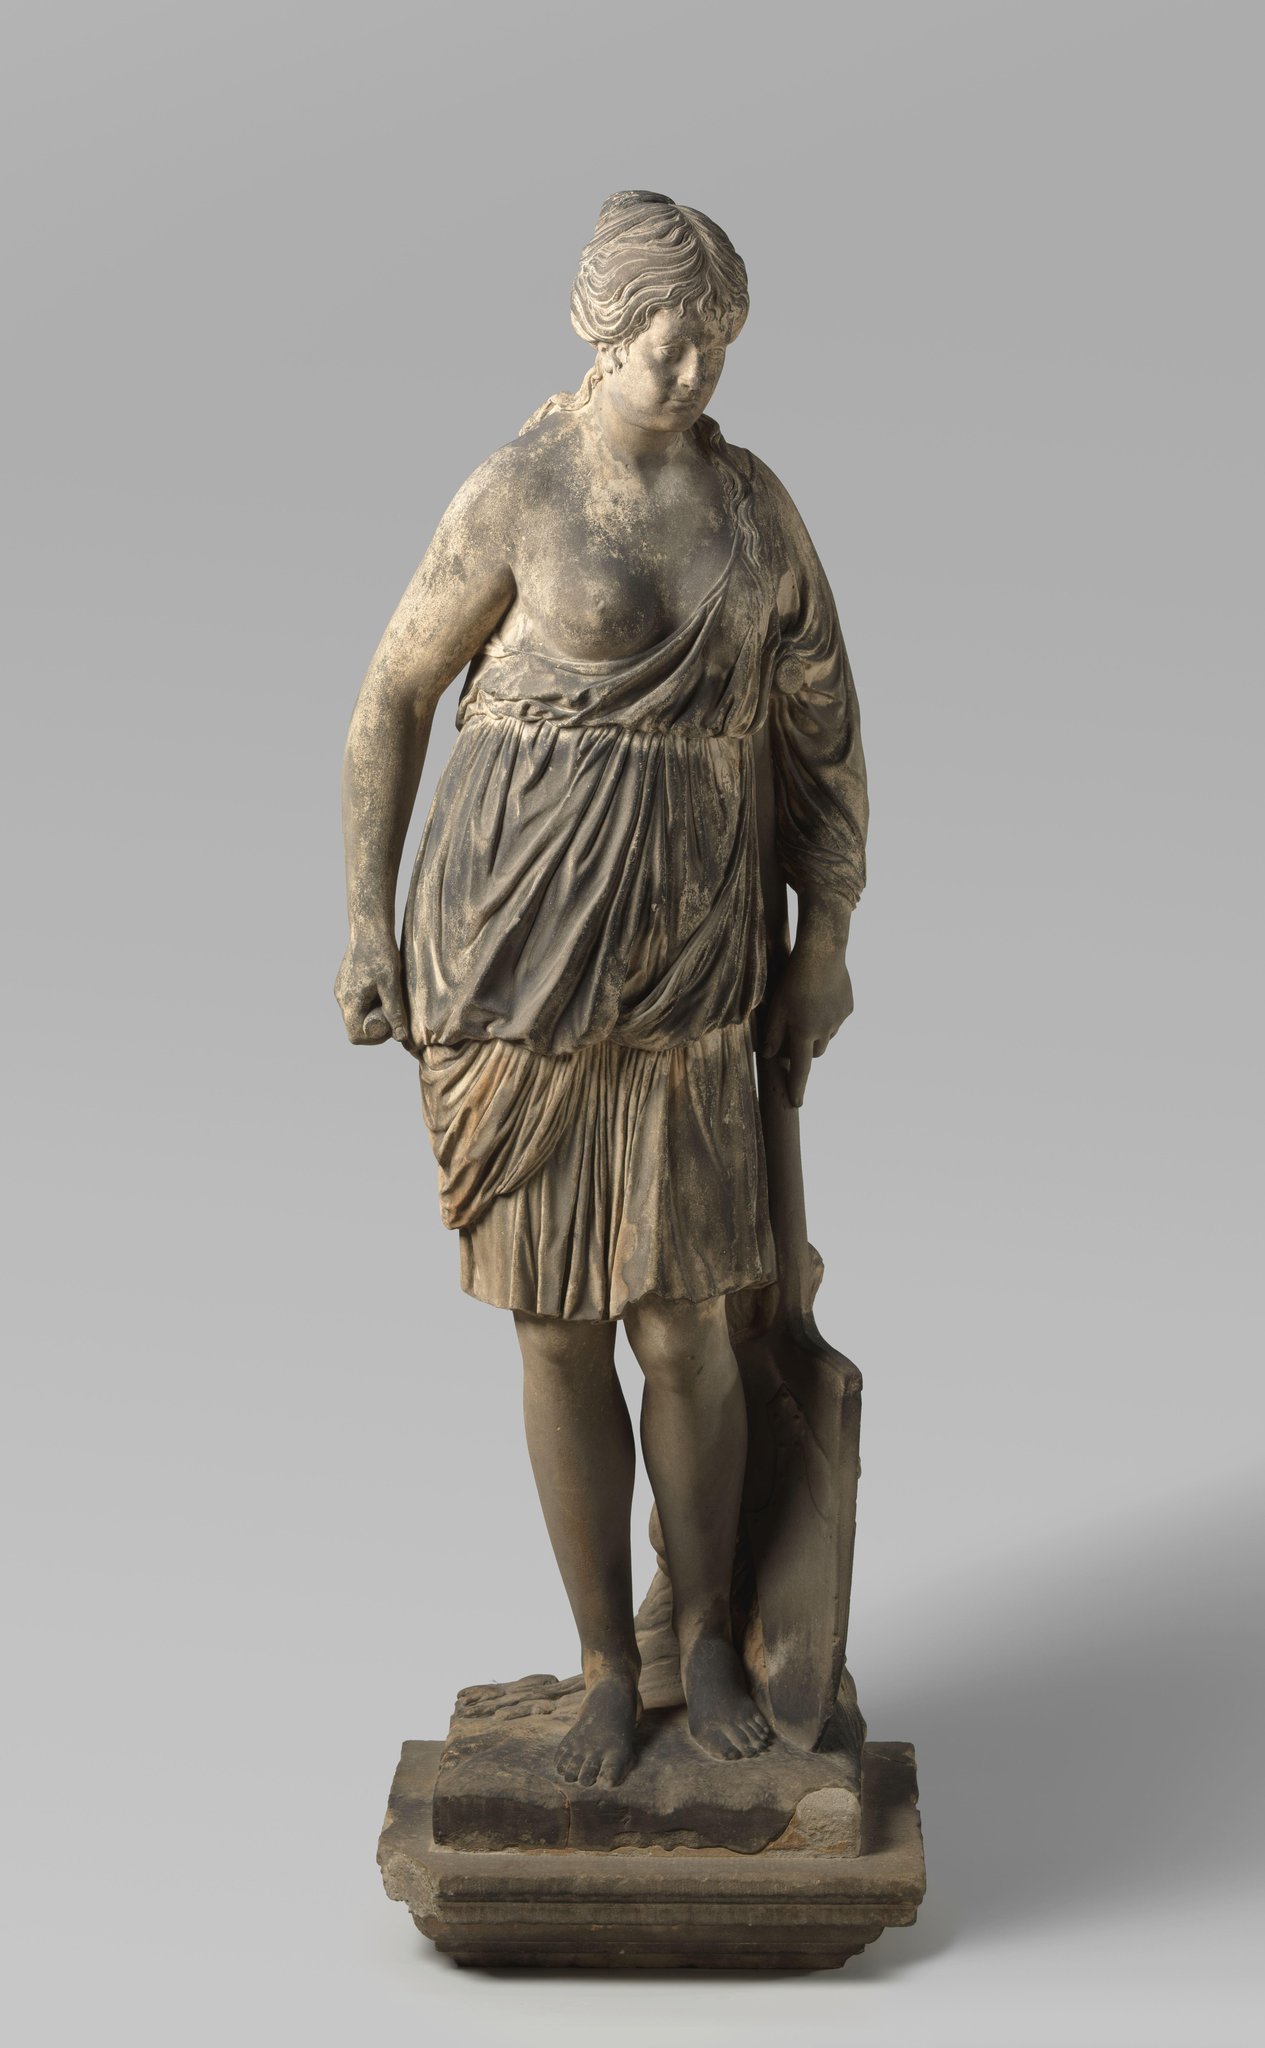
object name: sculpture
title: Providentia/Oeconomia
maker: pieter adriaensz t hooft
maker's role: sculptor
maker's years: 1610-1650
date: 1637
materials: stone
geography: the hague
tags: constantijn huygens (i)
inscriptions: monogram, on the reverse of the tree stump, incised: ‘PH’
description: Het beeld staat op het bovenblad van BK-18042-B-2.